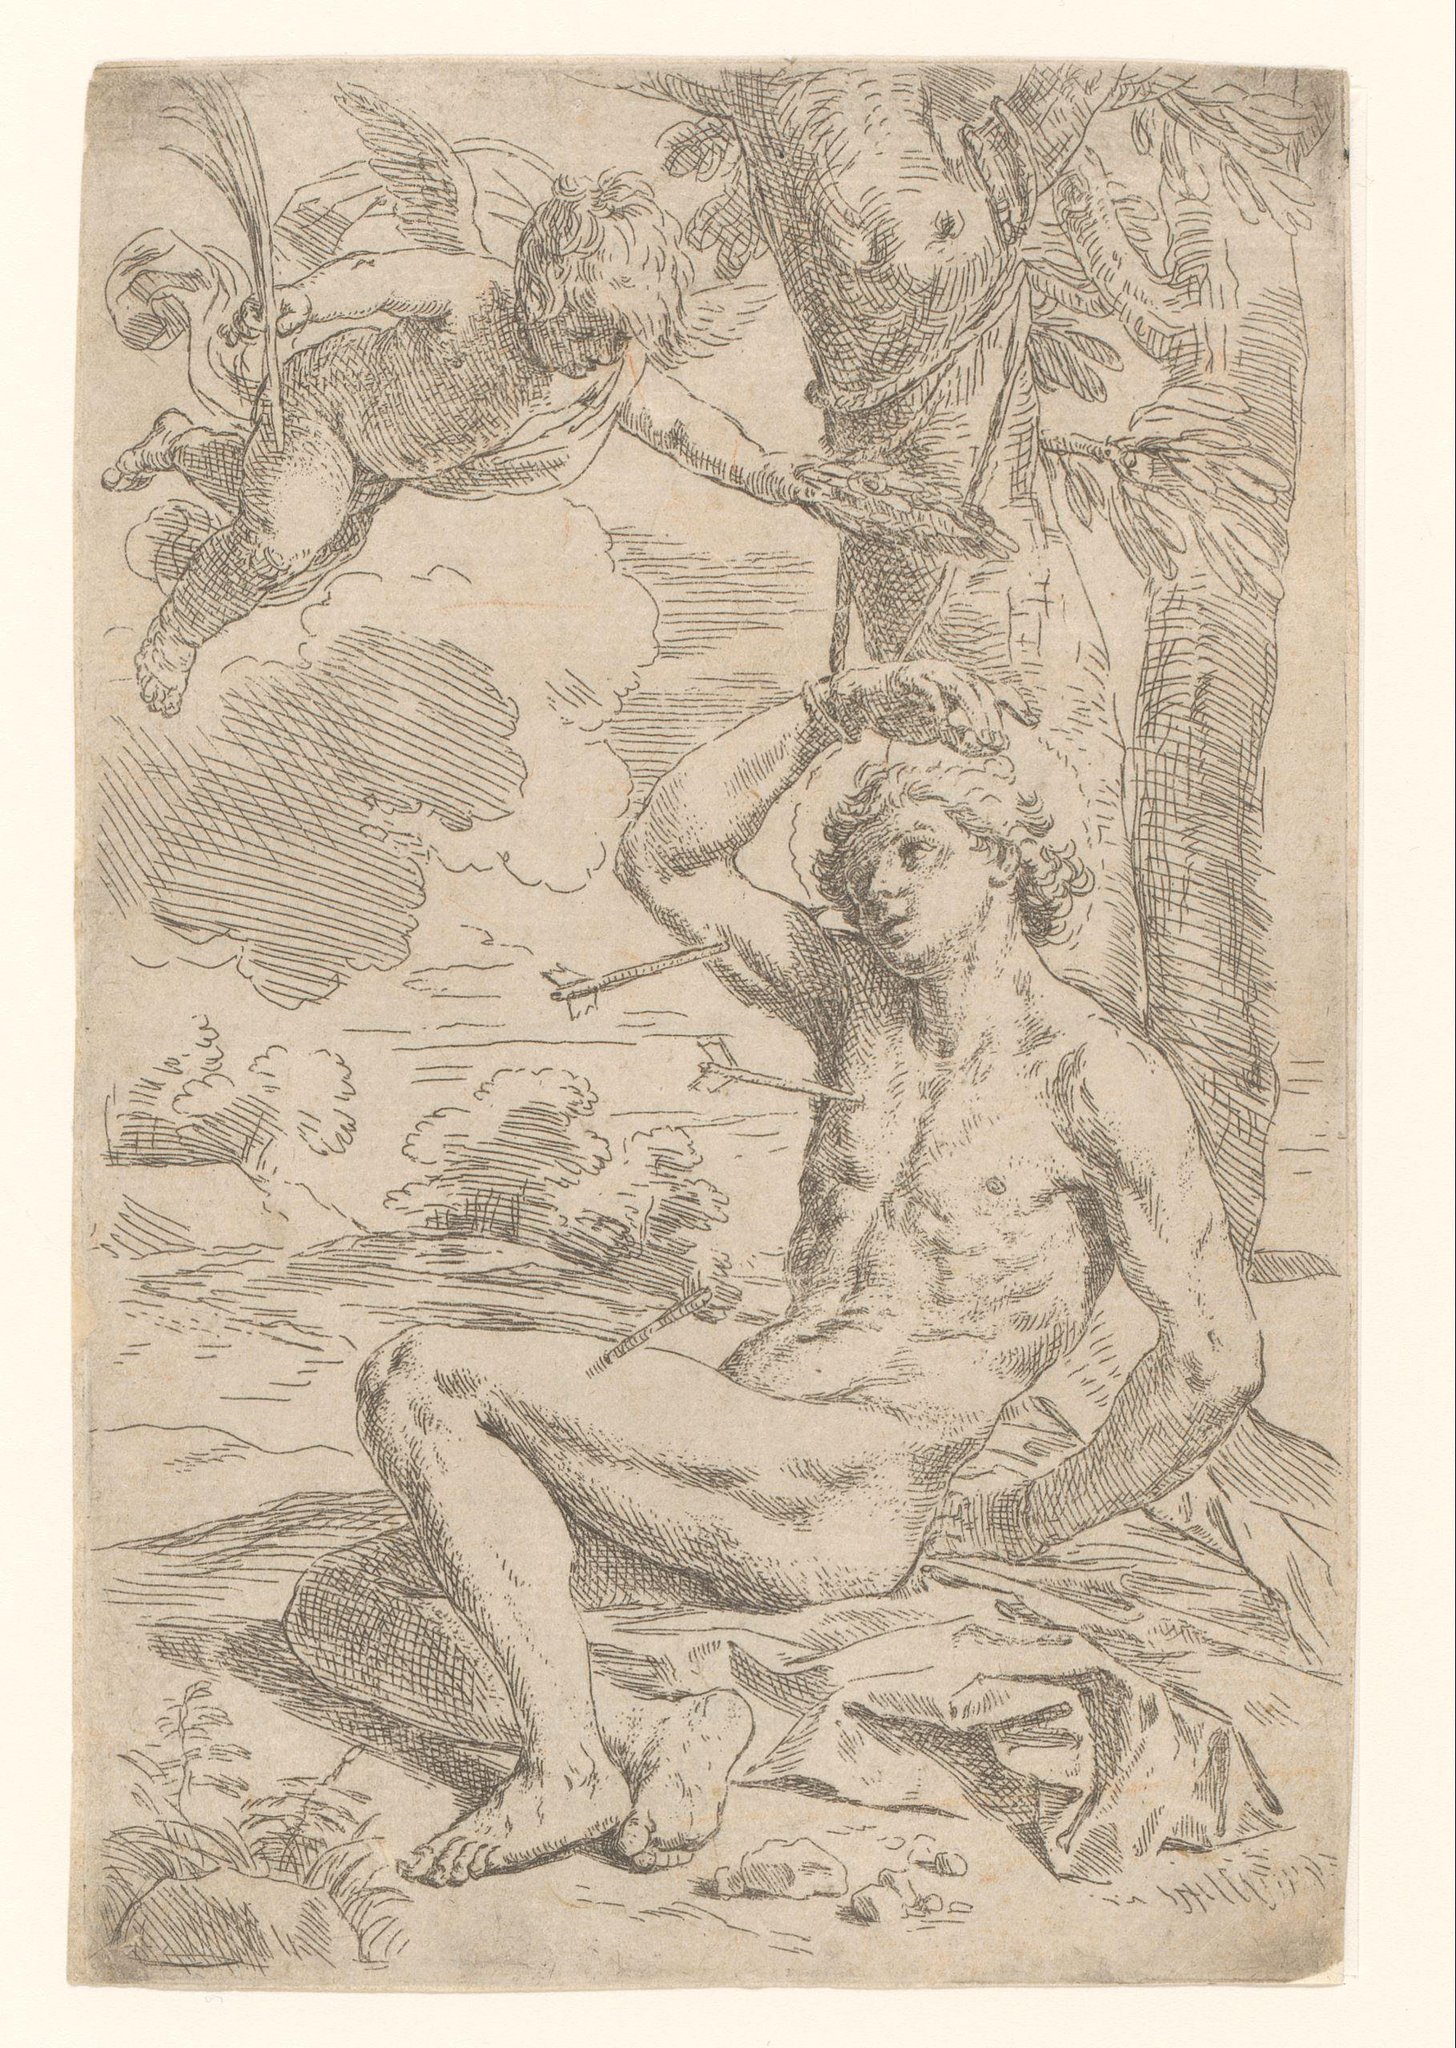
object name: print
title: Heilige Sebastiaan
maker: simone cantarini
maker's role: draughtsman, print maker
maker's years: 1612-1648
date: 1622-1648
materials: paper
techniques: etching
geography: italy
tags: martyrdom, suffering, misfortune, death of st. sebastian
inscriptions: inscription: ‘guido Reni 15f’, inscription: ‘Cantarini/ B24’, collector's mark: Lugt 2228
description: De heilige Sebastiaan zit tegen een boom, doorzeefd met pijlen. Een engel zweeft boven hem en houdt een lauwerkrans boven zijn hoofd.